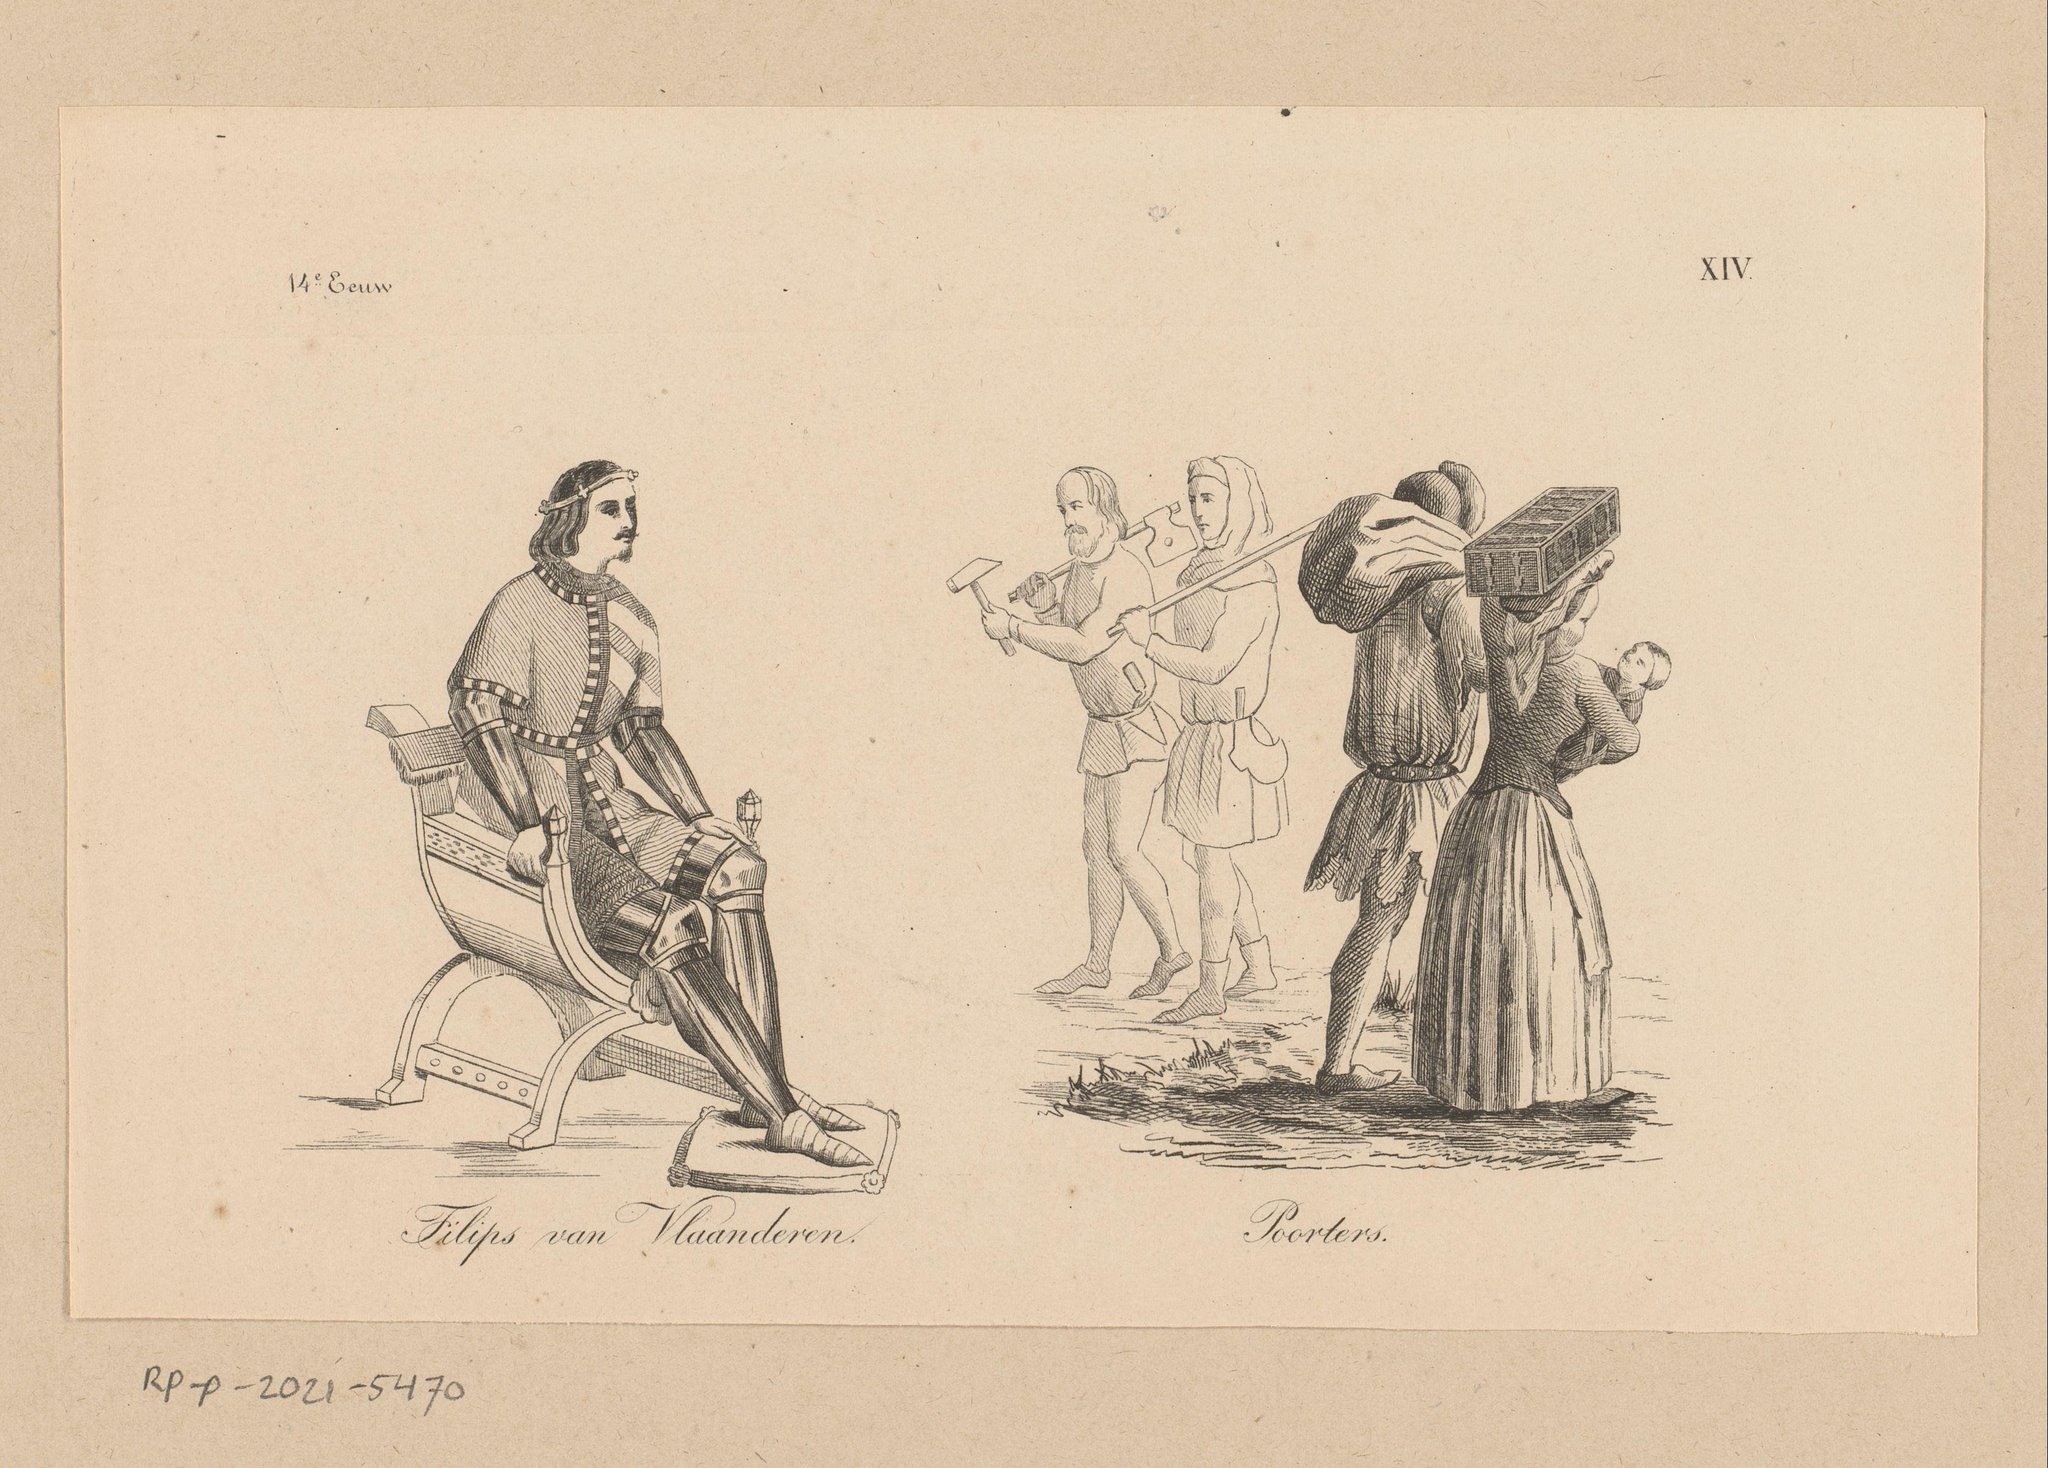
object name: print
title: Filips van Vlaanderen en poorters in kleding uit de veertiende eeuw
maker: Anonymous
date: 1857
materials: paper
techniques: lithograph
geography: netherlands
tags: parents with their children, clothes, costume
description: Prent waarschijnlijk uit: Hofdijk, Willem Jacob. Schets van de geschiedenis der Nederlanden. Amsterdam: Gebroeders Binger, 1857.